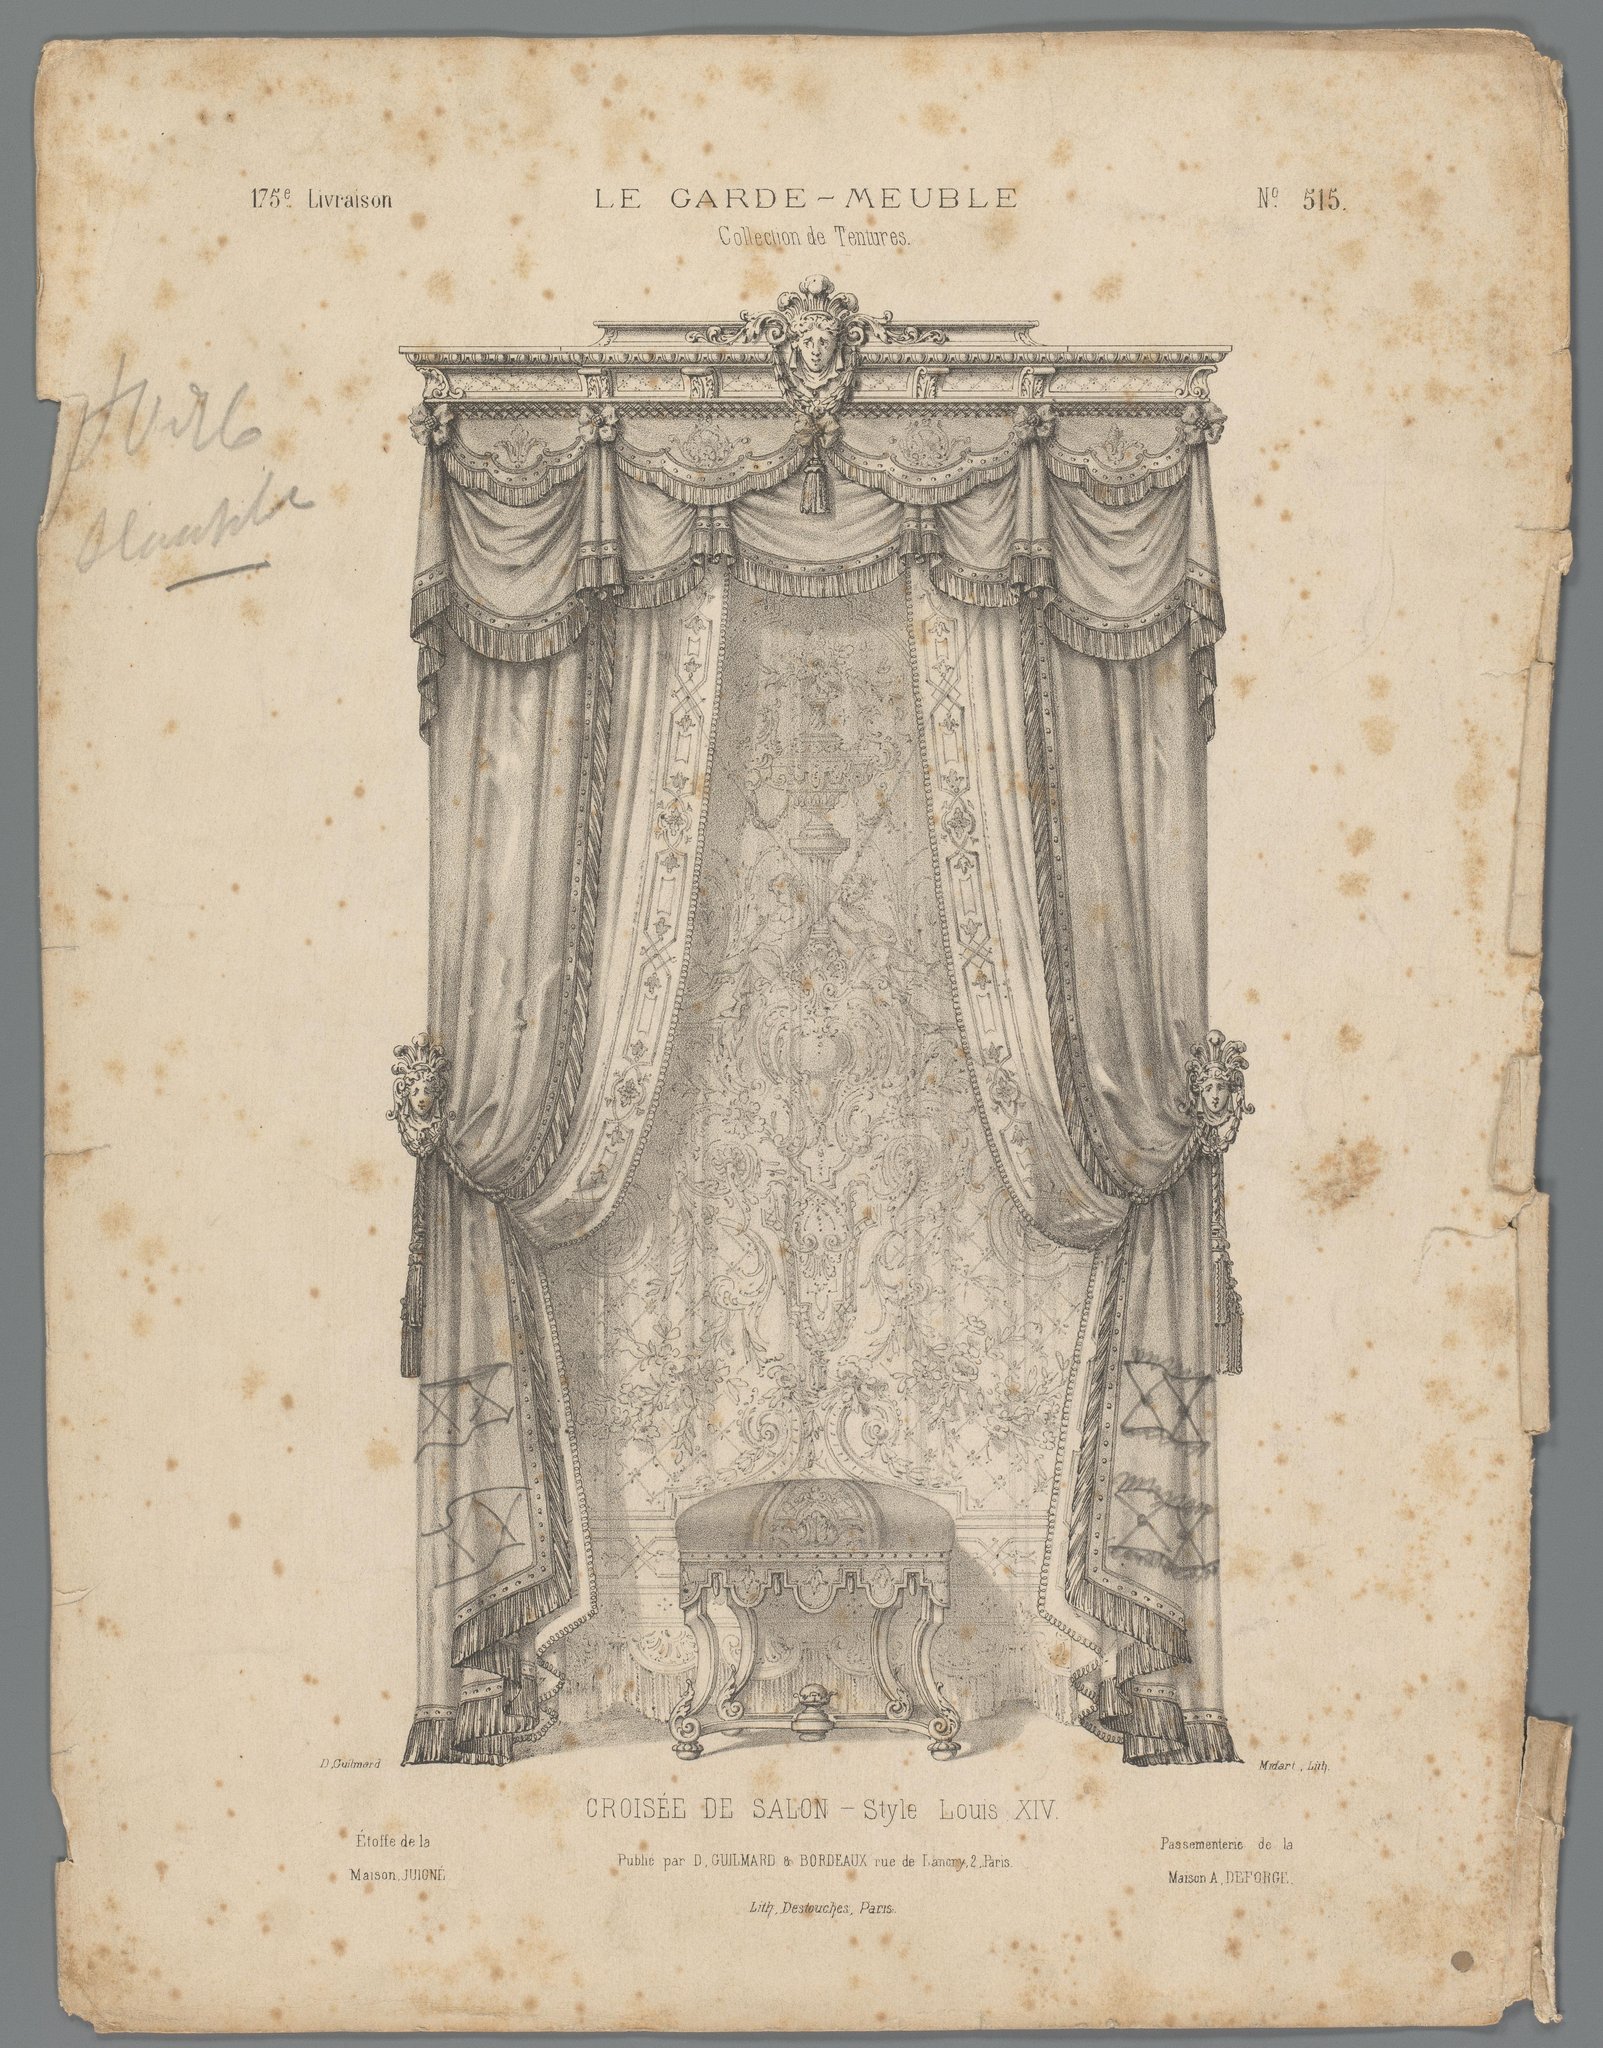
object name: print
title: Salonvenster met gordijnen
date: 1853-1869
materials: paper, pencil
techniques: lithograph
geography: paris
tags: window, living-room, parlour, sitting-room, hangings and drapery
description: Salonvenster met gedrapeerde gordijnen in de Lodewijk XIV-stijl. Prent uit 175e Livraison.